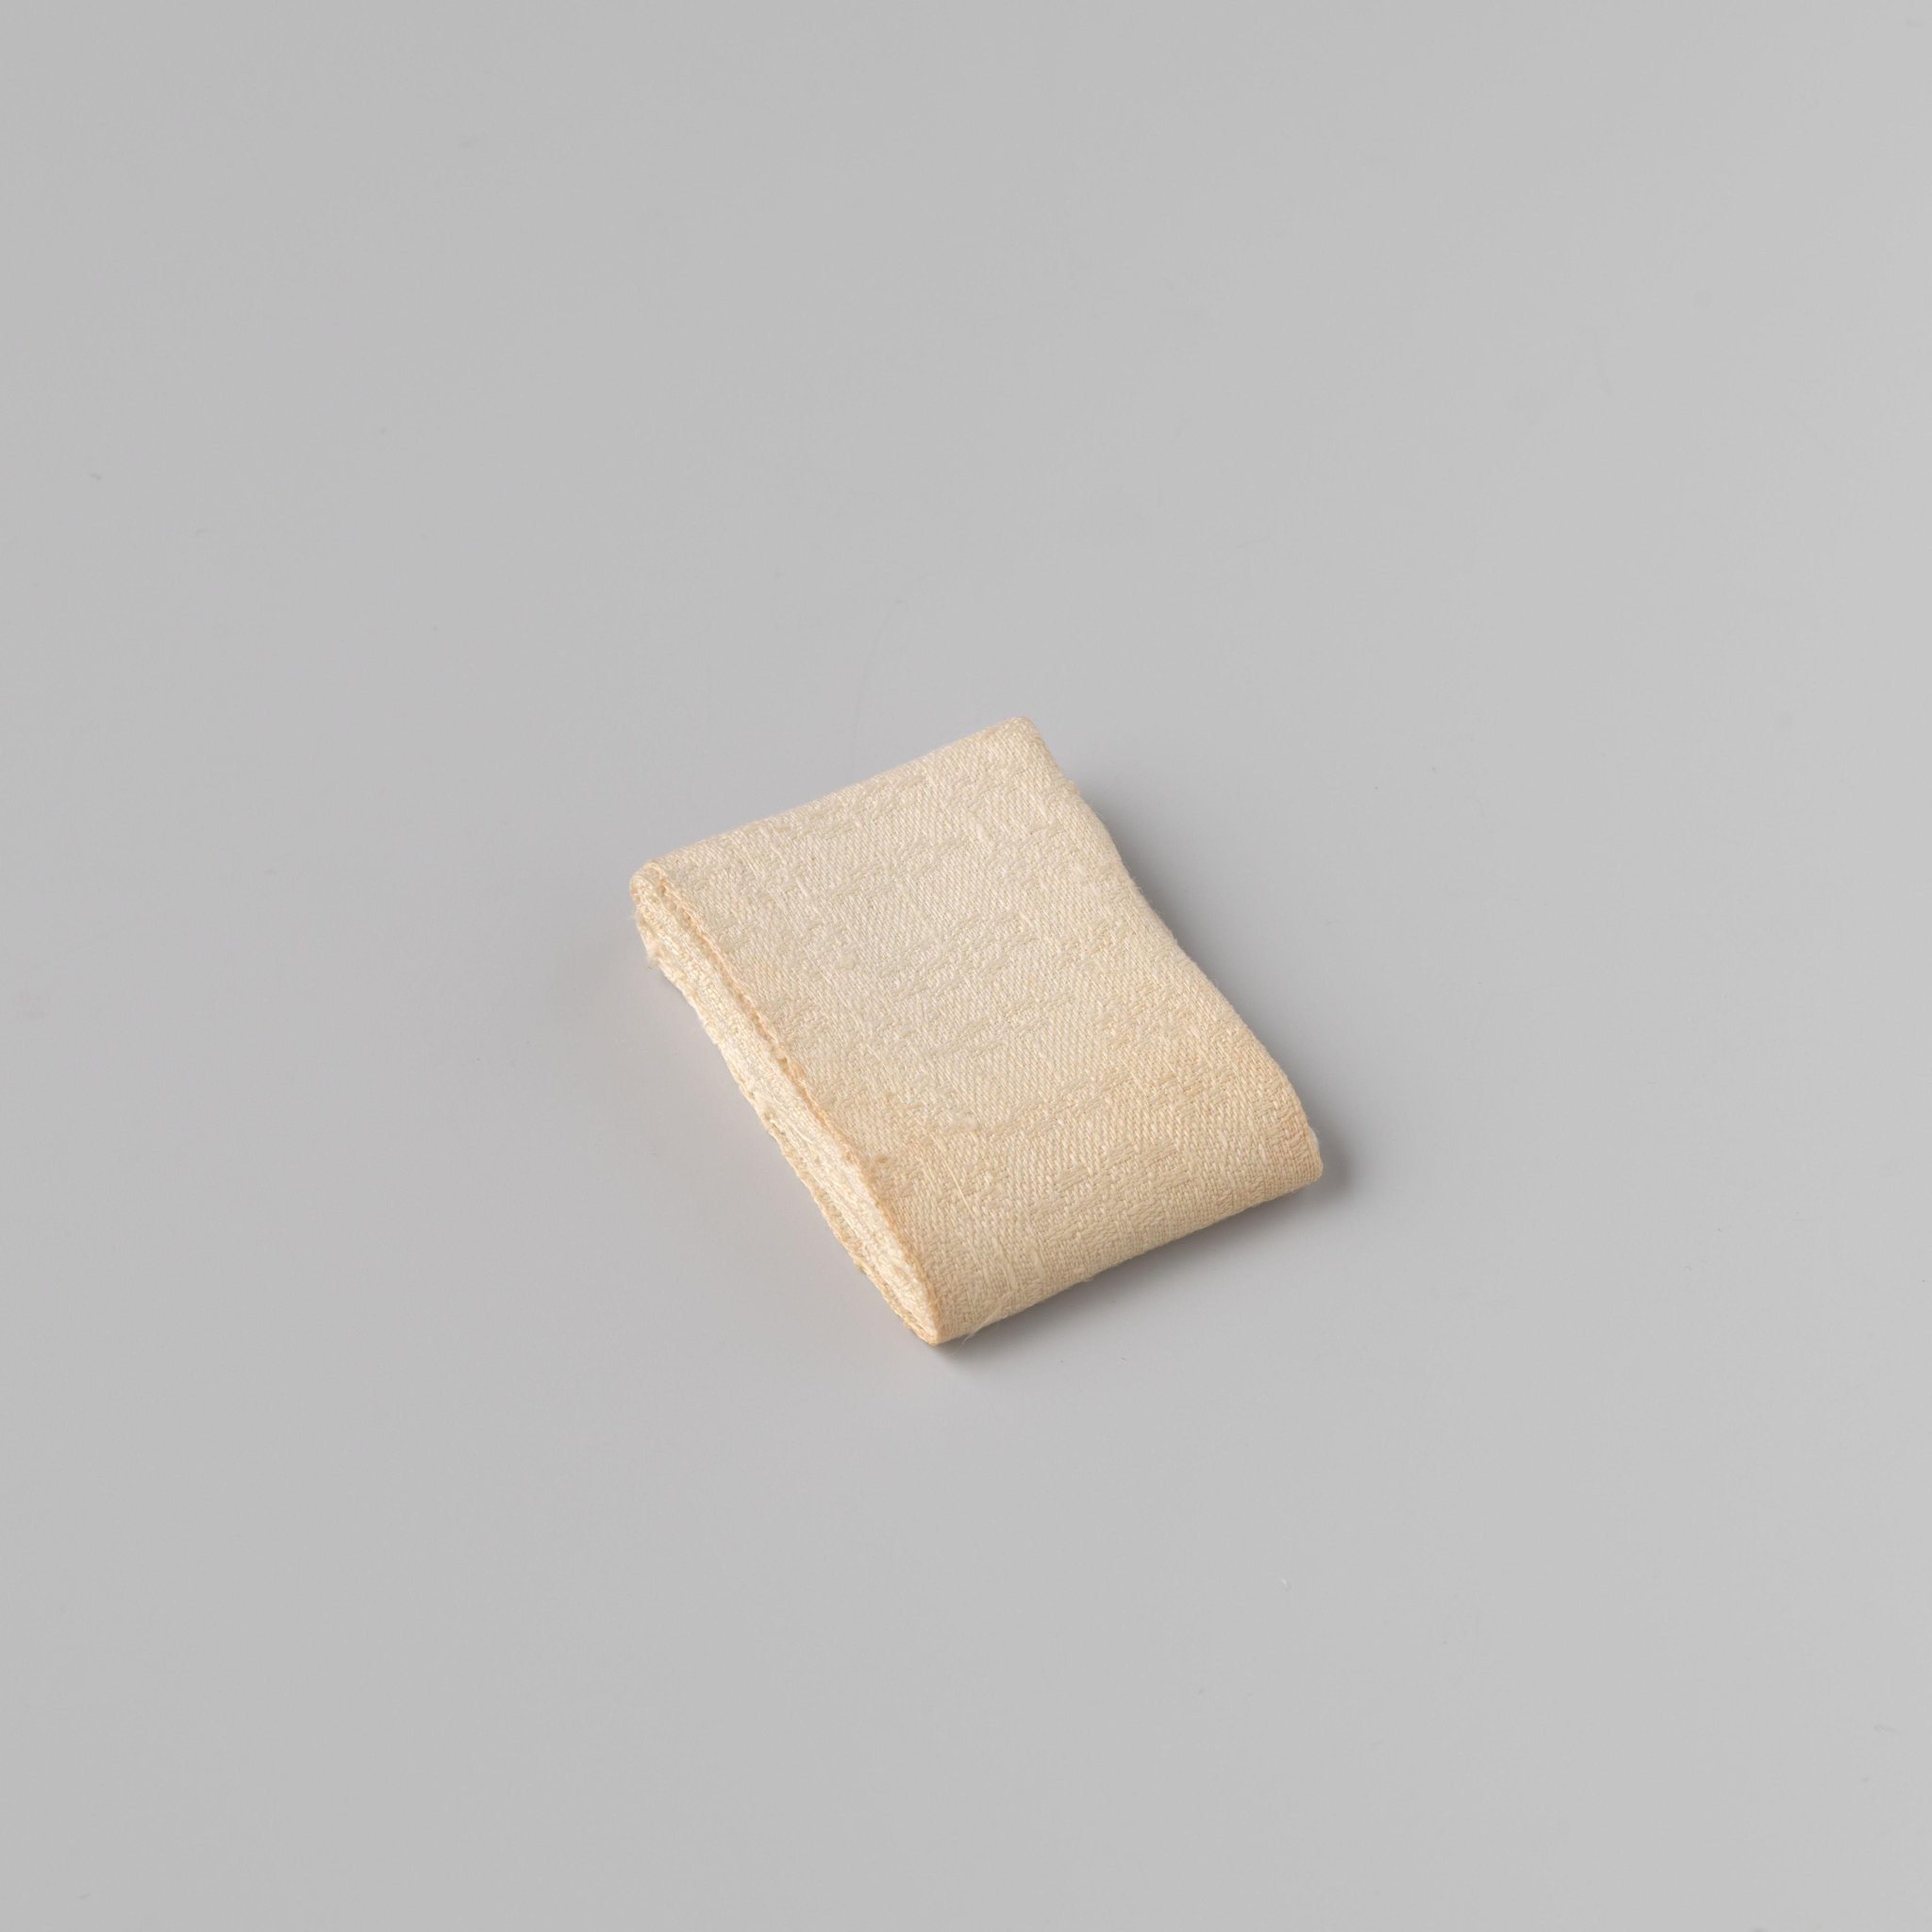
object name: napkin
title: Linnen servet van damastweefsel met pellenpatroon (motief III), geen zomen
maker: Anonymous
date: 1690-1710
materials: linen